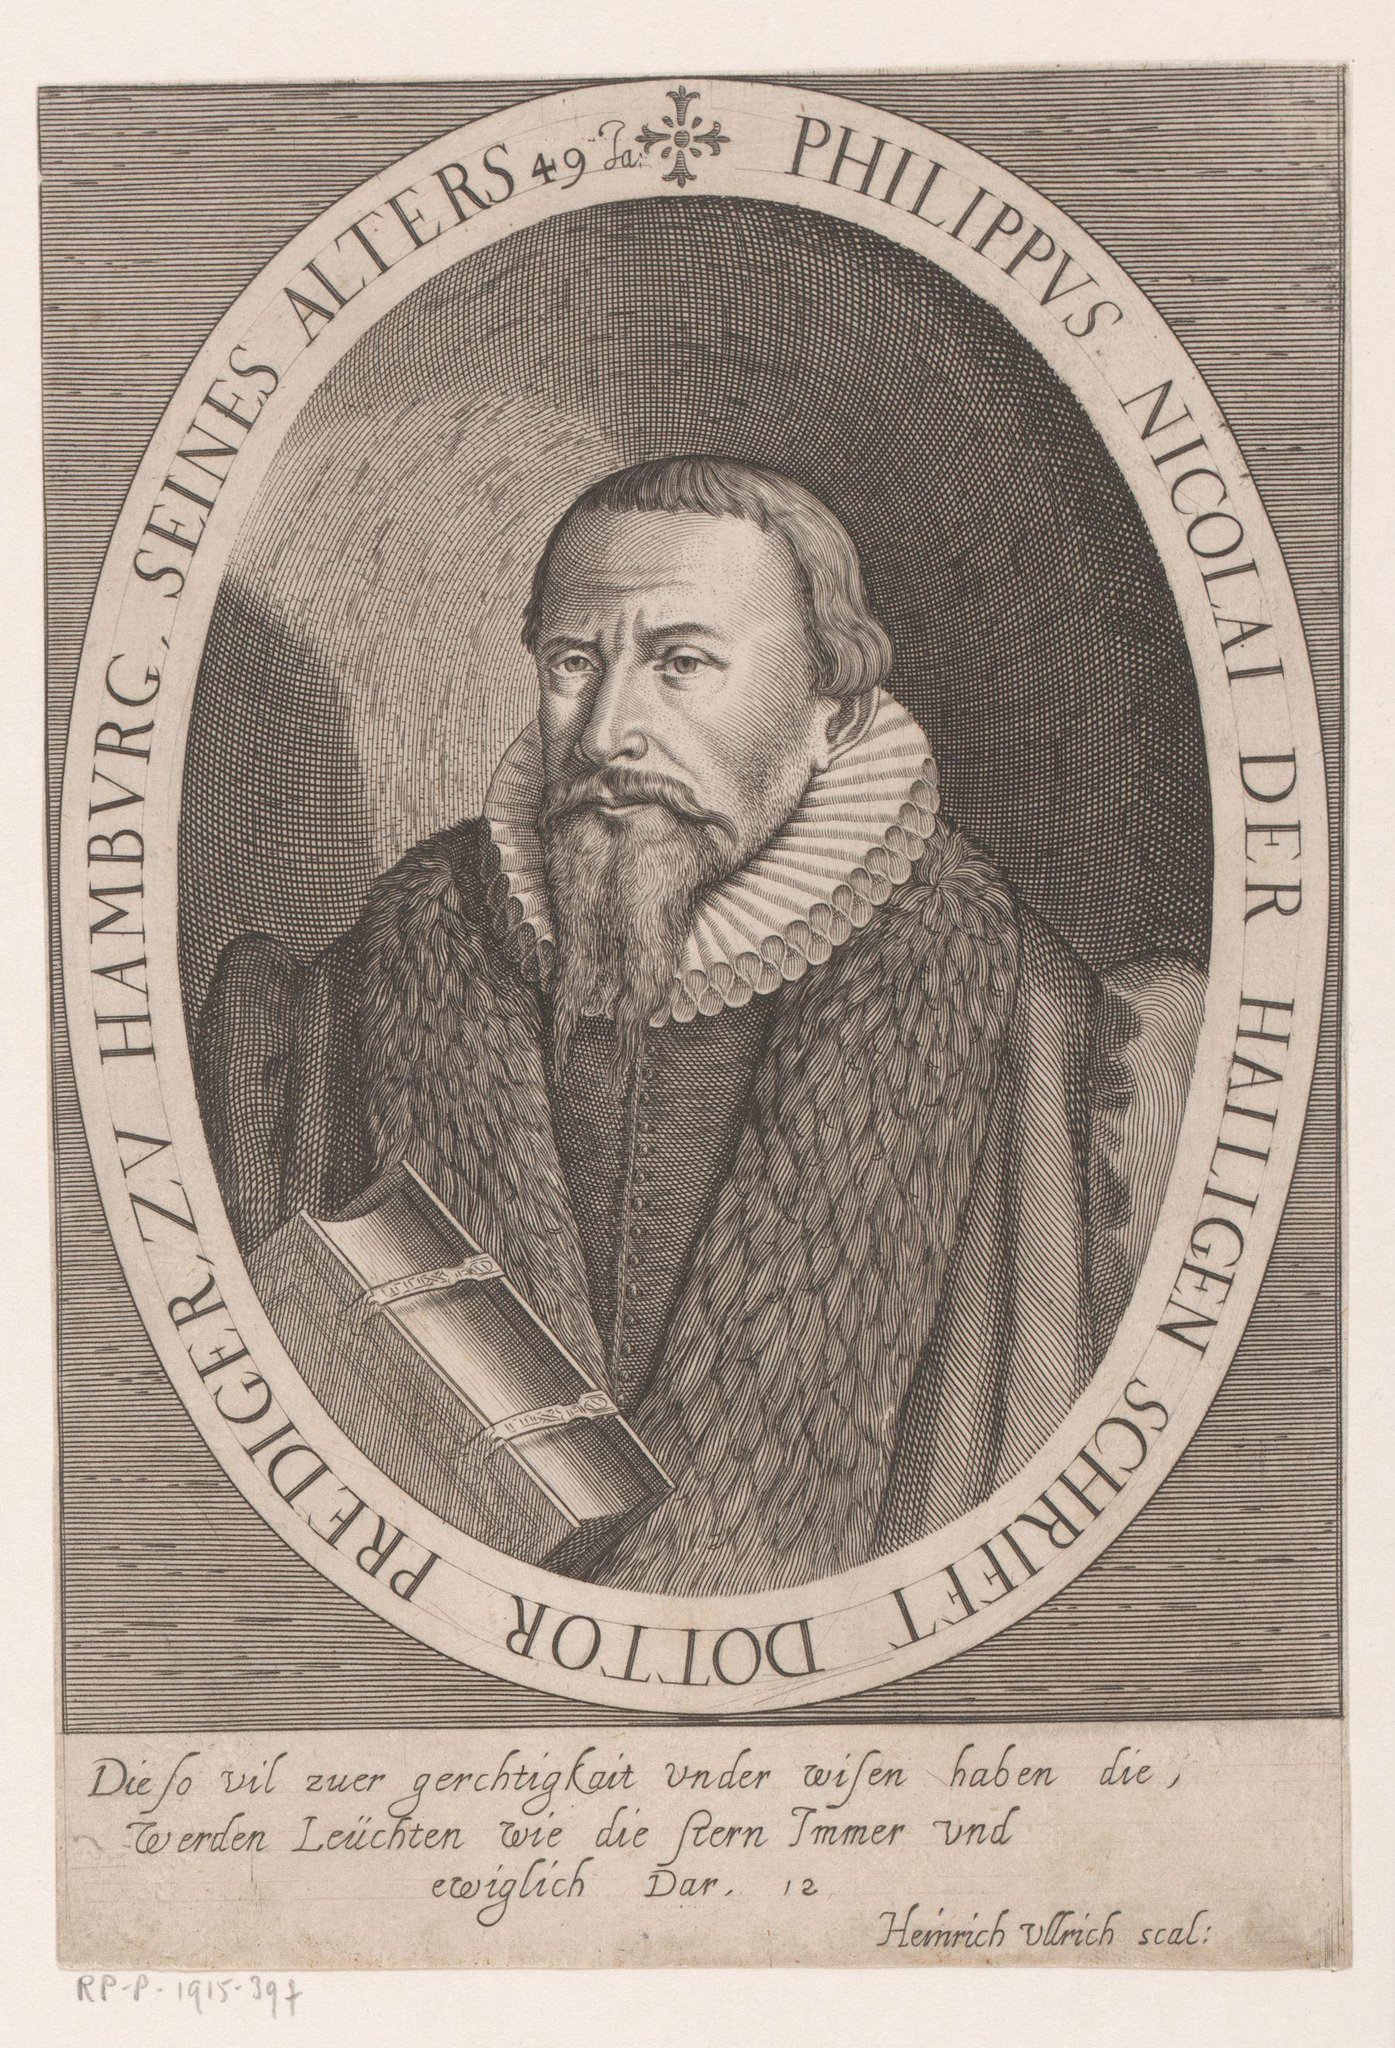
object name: print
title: Portret van Philipp Nicolai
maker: heinrich ulrich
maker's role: draughtsman, painter, print maker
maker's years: 1572-1671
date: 1605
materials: paper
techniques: engraving, intaglio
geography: germany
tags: historical persons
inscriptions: collector's mark: Lugt 2228